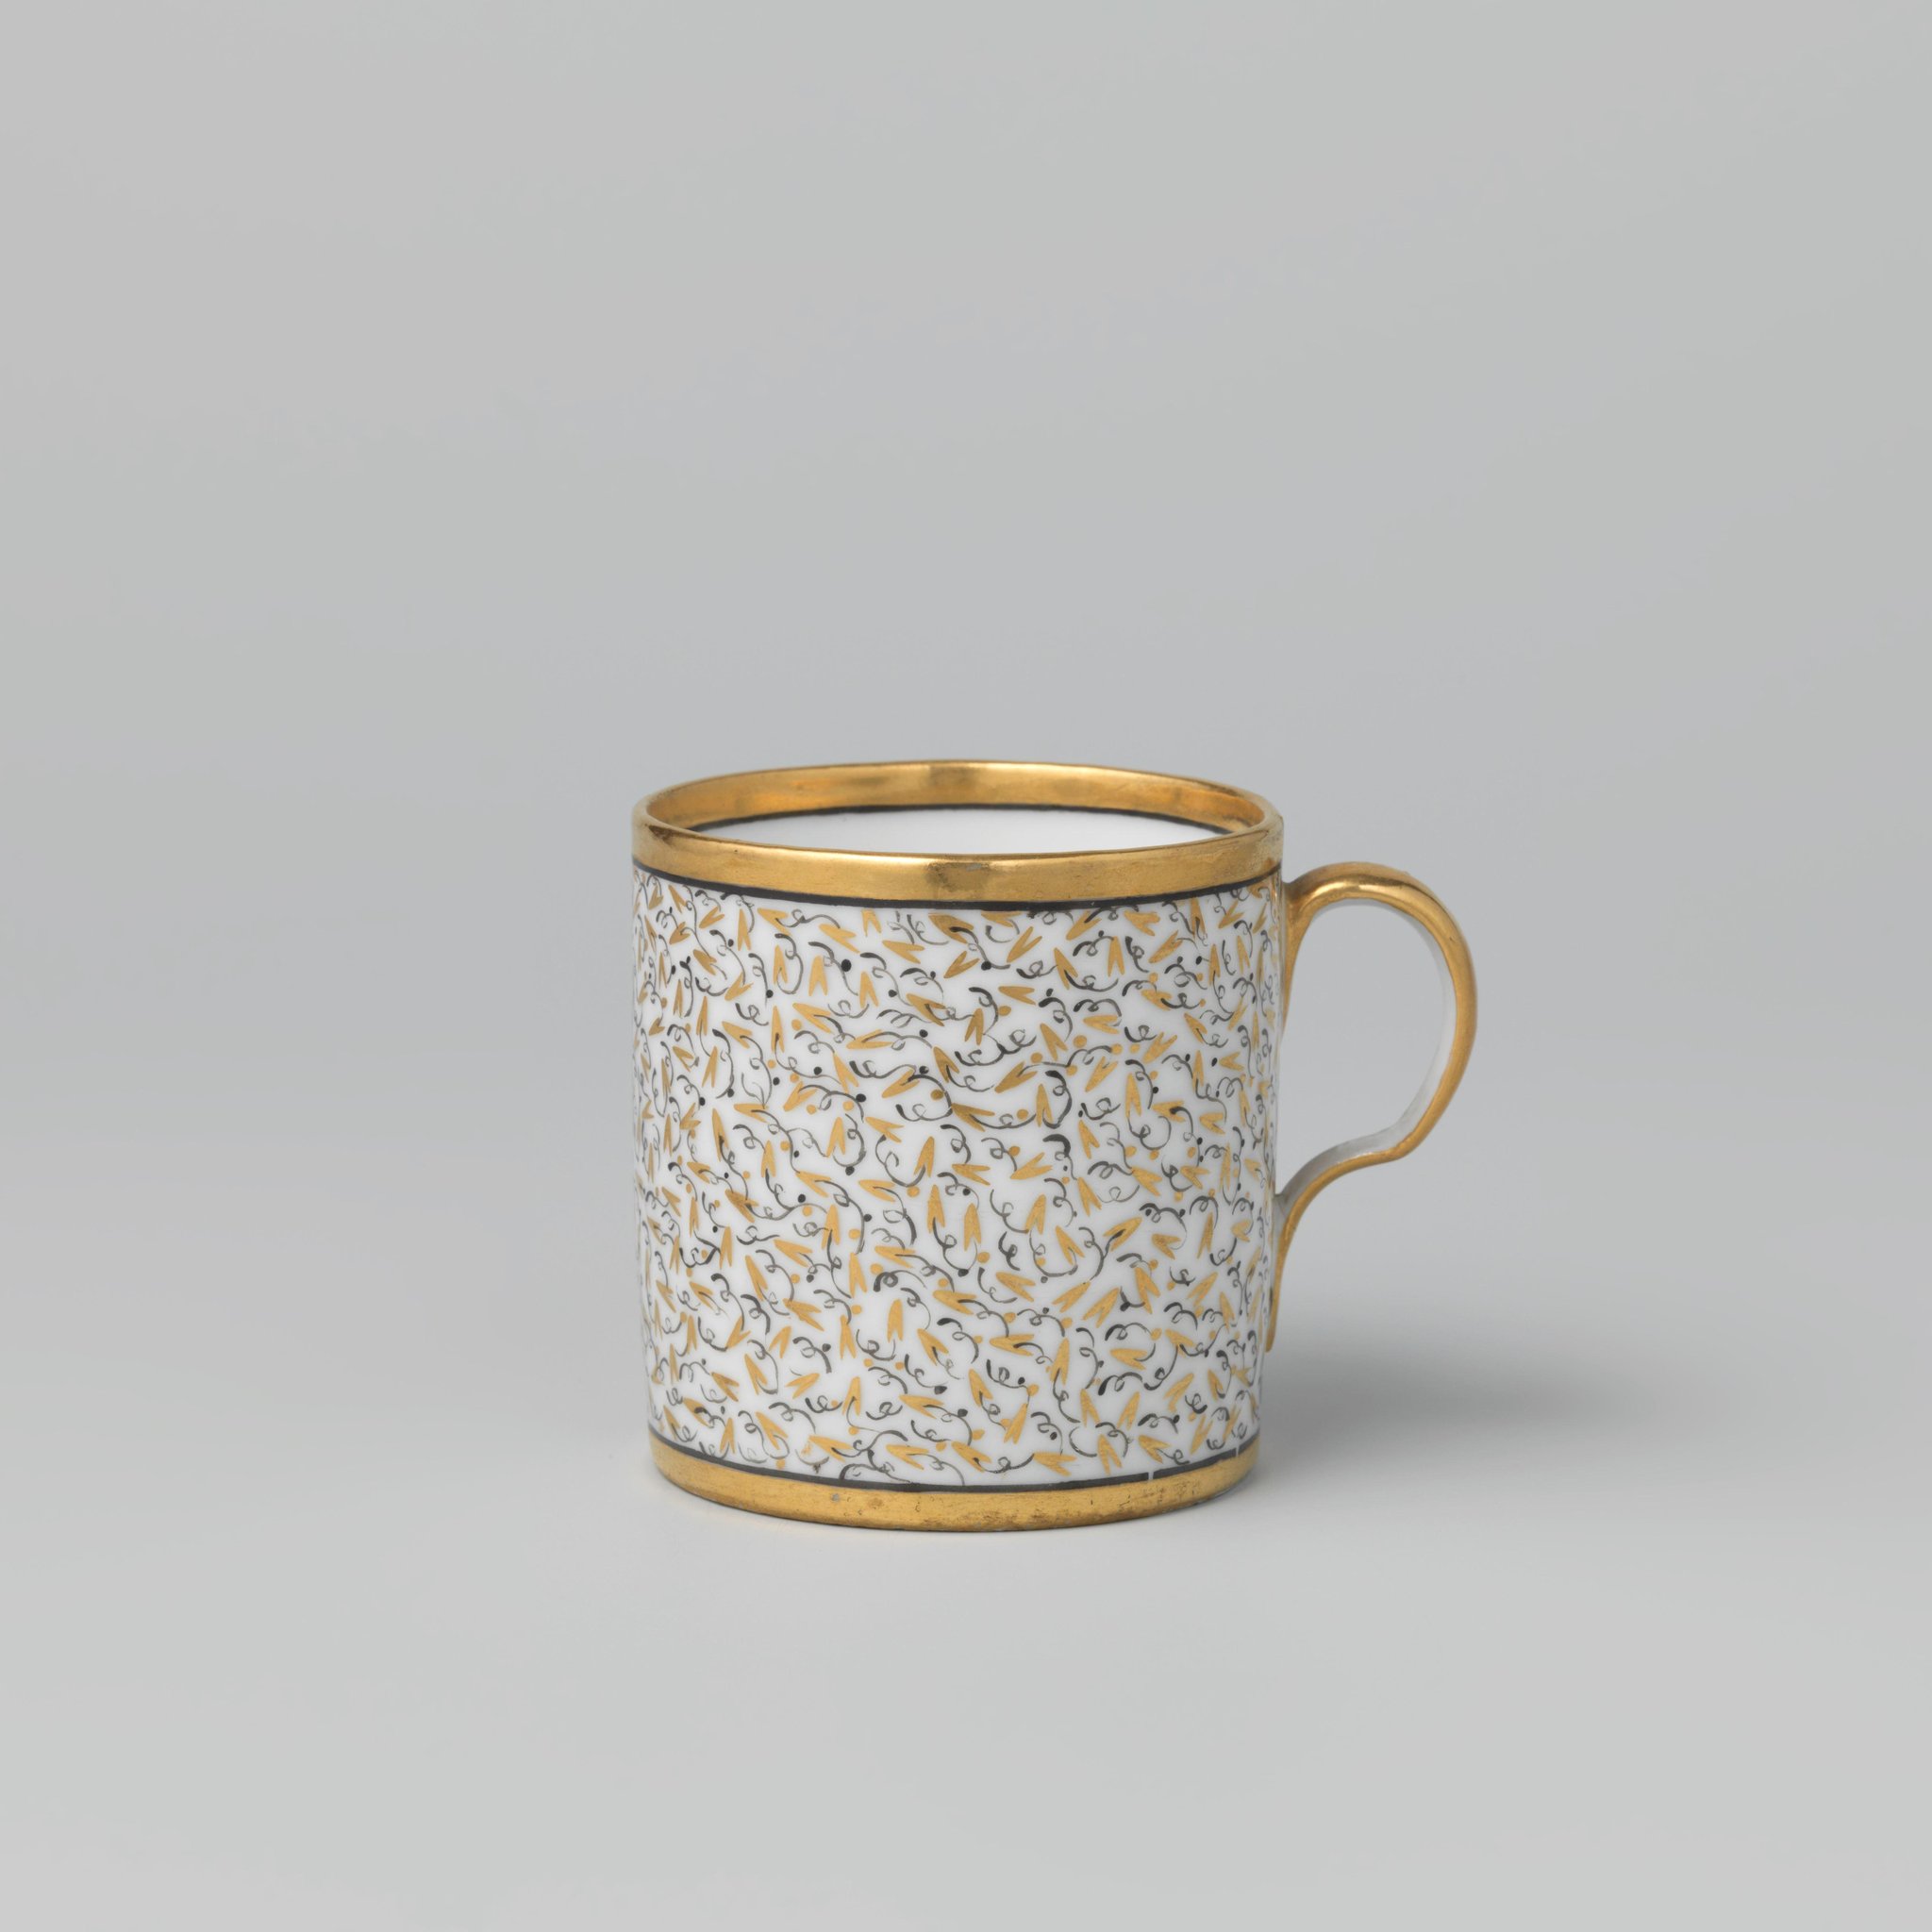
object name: cup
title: Cup with continuous foliate scrolls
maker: Anonymous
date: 1790-1800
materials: glaze, gold, paint, porcelain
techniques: forming, gilding, turning, vitrification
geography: france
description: Kop van porselein met een cilindrische wand en C-vormig oor, beschilderd op het glazuur in zwart en goud. Op de buitenwand een doorlopend patroon van bladranken. Gouden band boven de voet en op de rand. Gouden oor.